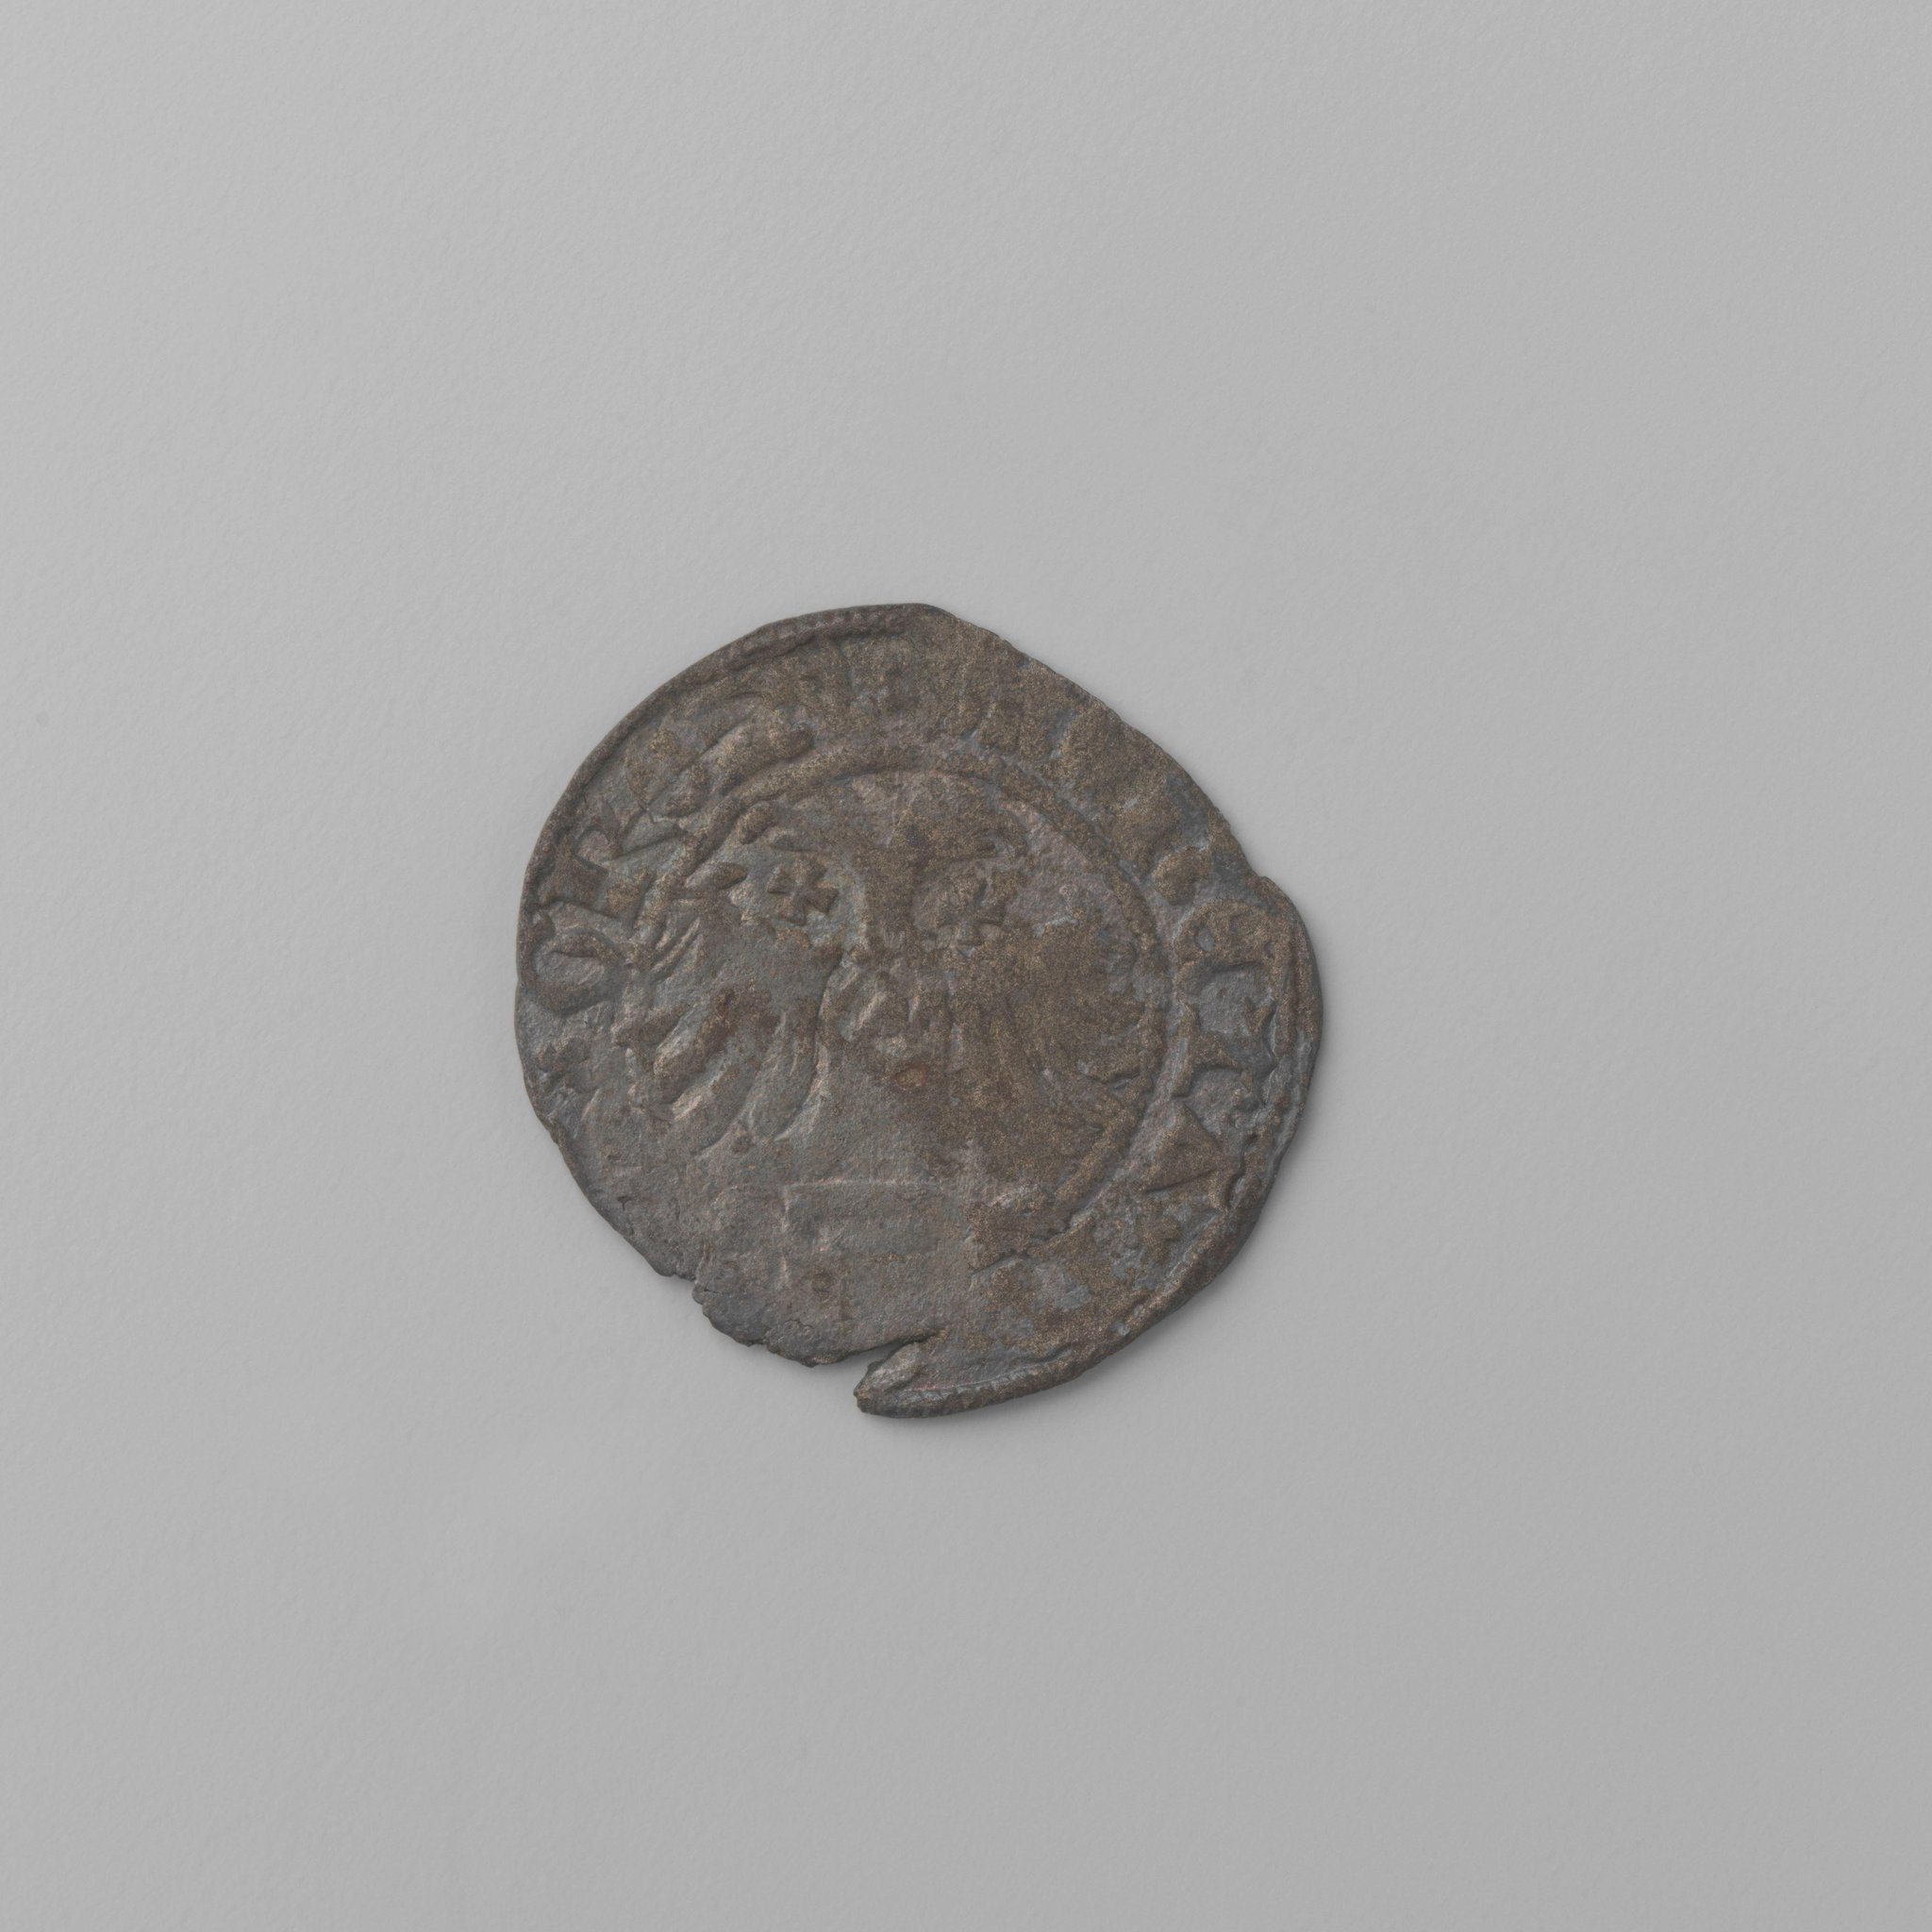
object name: coin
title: Groningse plak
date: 1425-1506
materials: silver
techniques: striking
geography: groningen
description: Zilveren munt. Voorzijde: dubbelkoppige adelaar met kruisje onder elke kop, onder de adelaar wapenschildje. Keerzijde: lang gevoet kruis, in het hart wapenschildje.